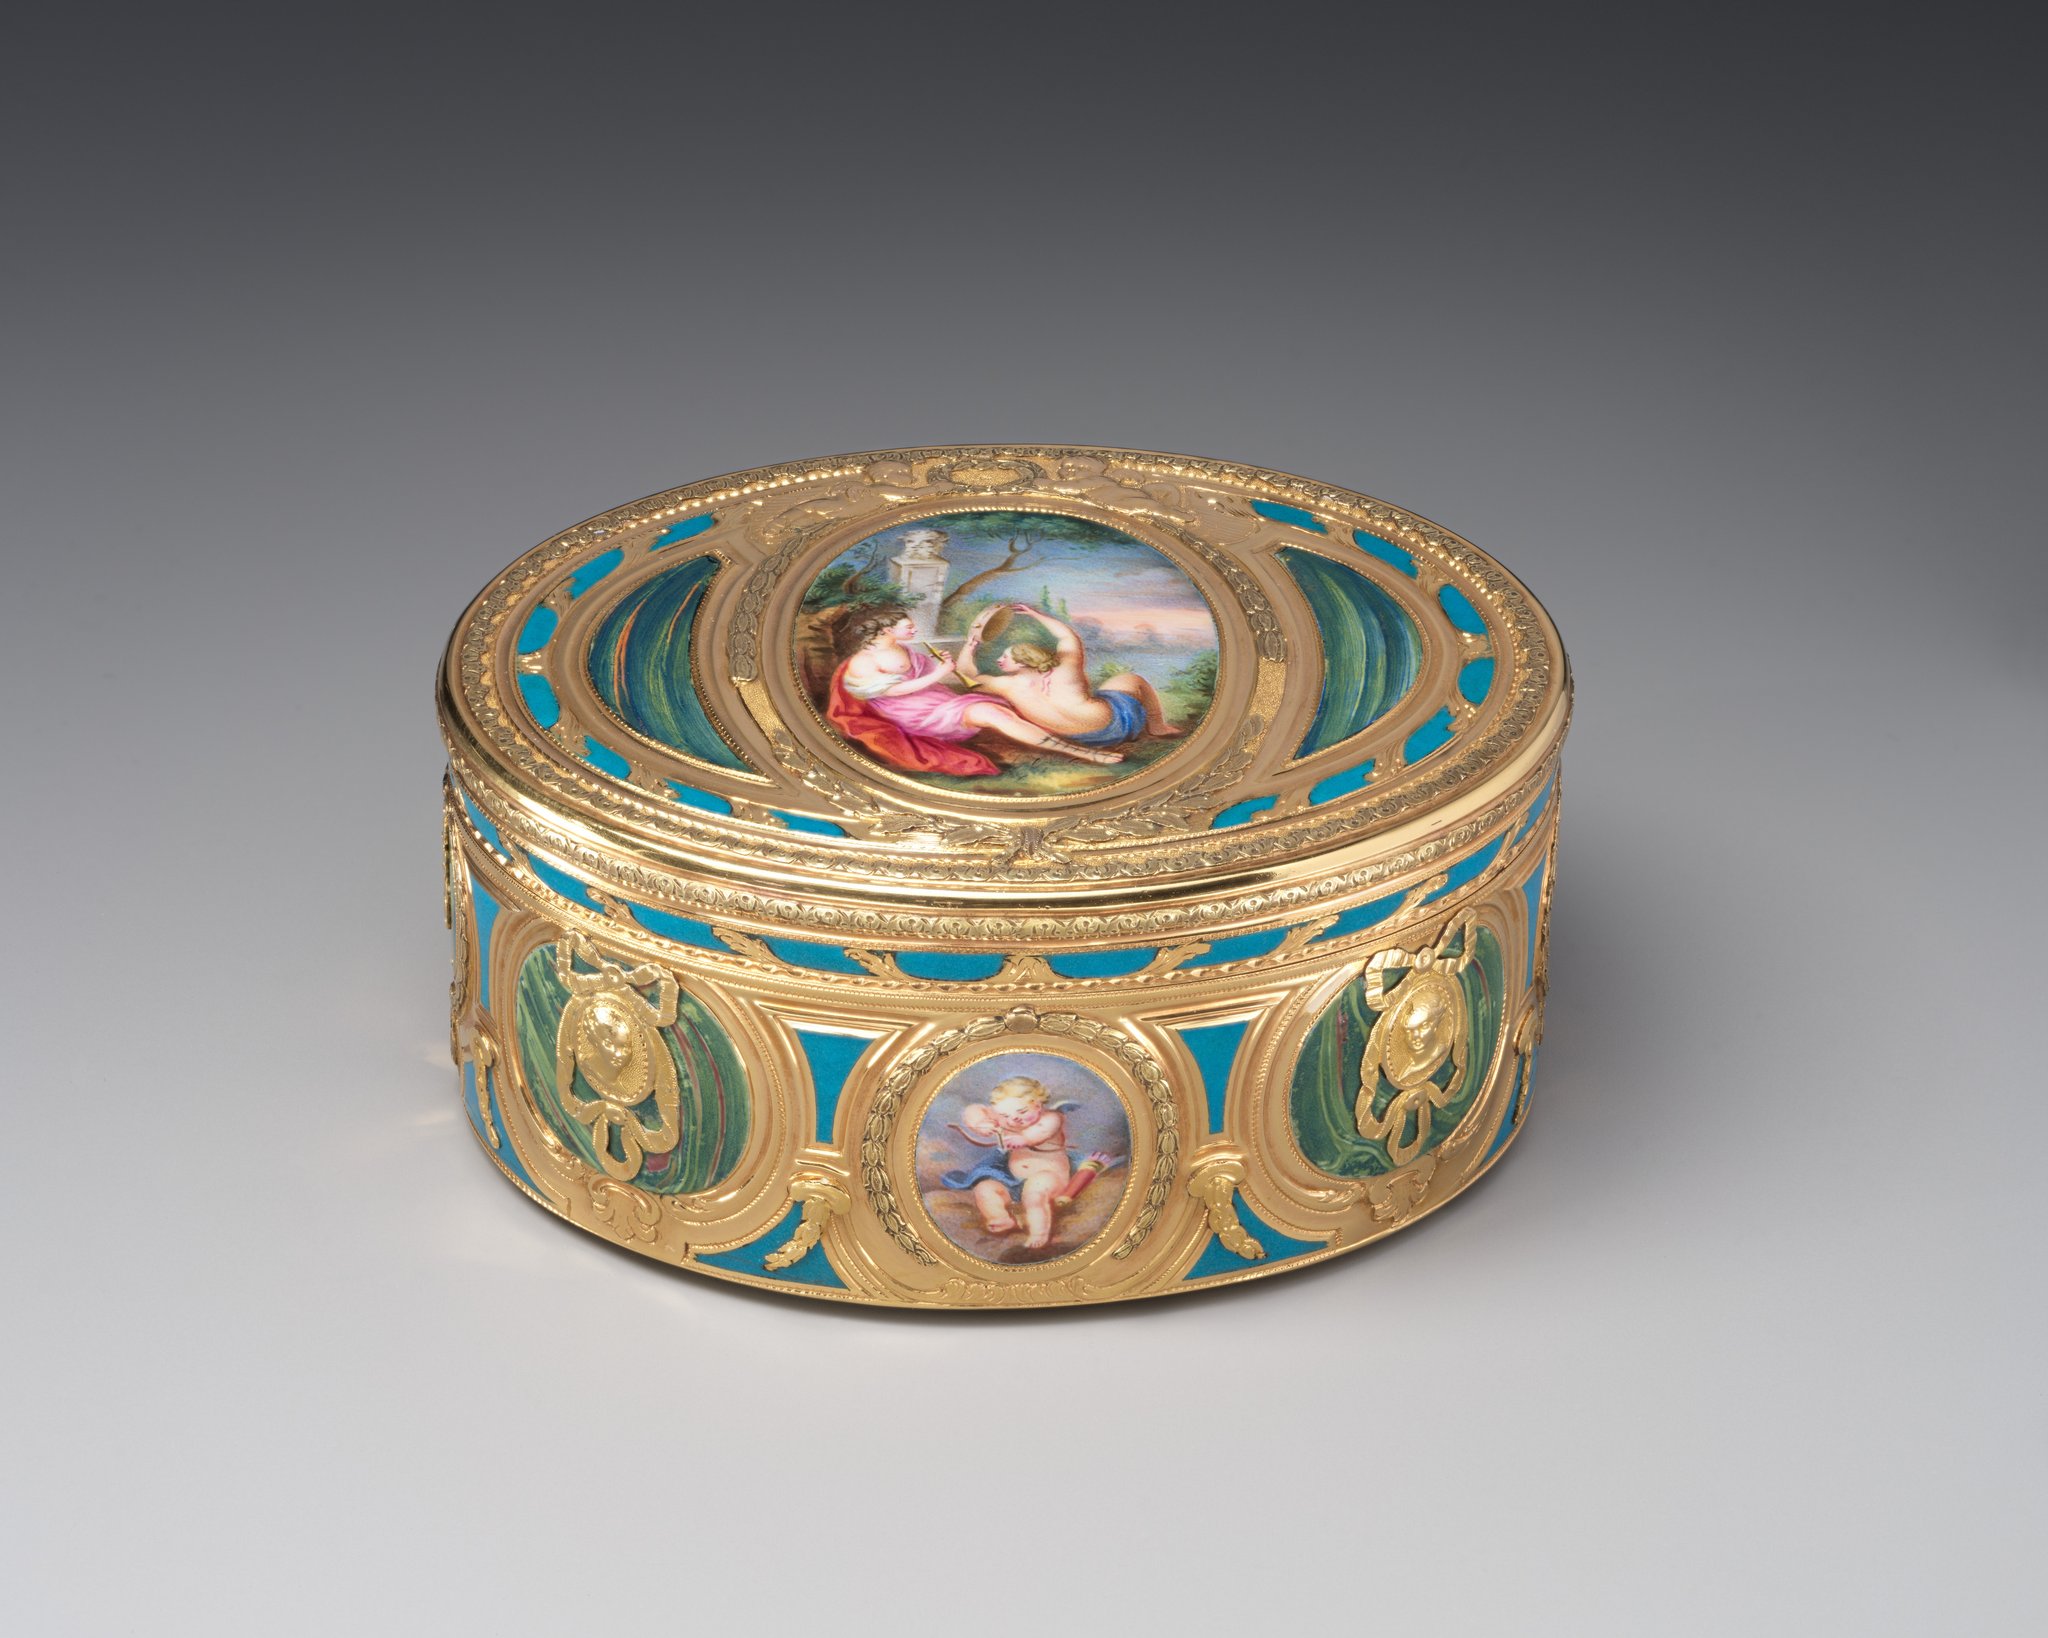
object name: snuffbox, painting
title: Snuffbox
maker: jean-joseph barrière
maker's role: maker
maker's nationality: french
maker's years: 1733-1833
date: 1769-1770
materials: enamel, gold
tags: musical instruments,men,women